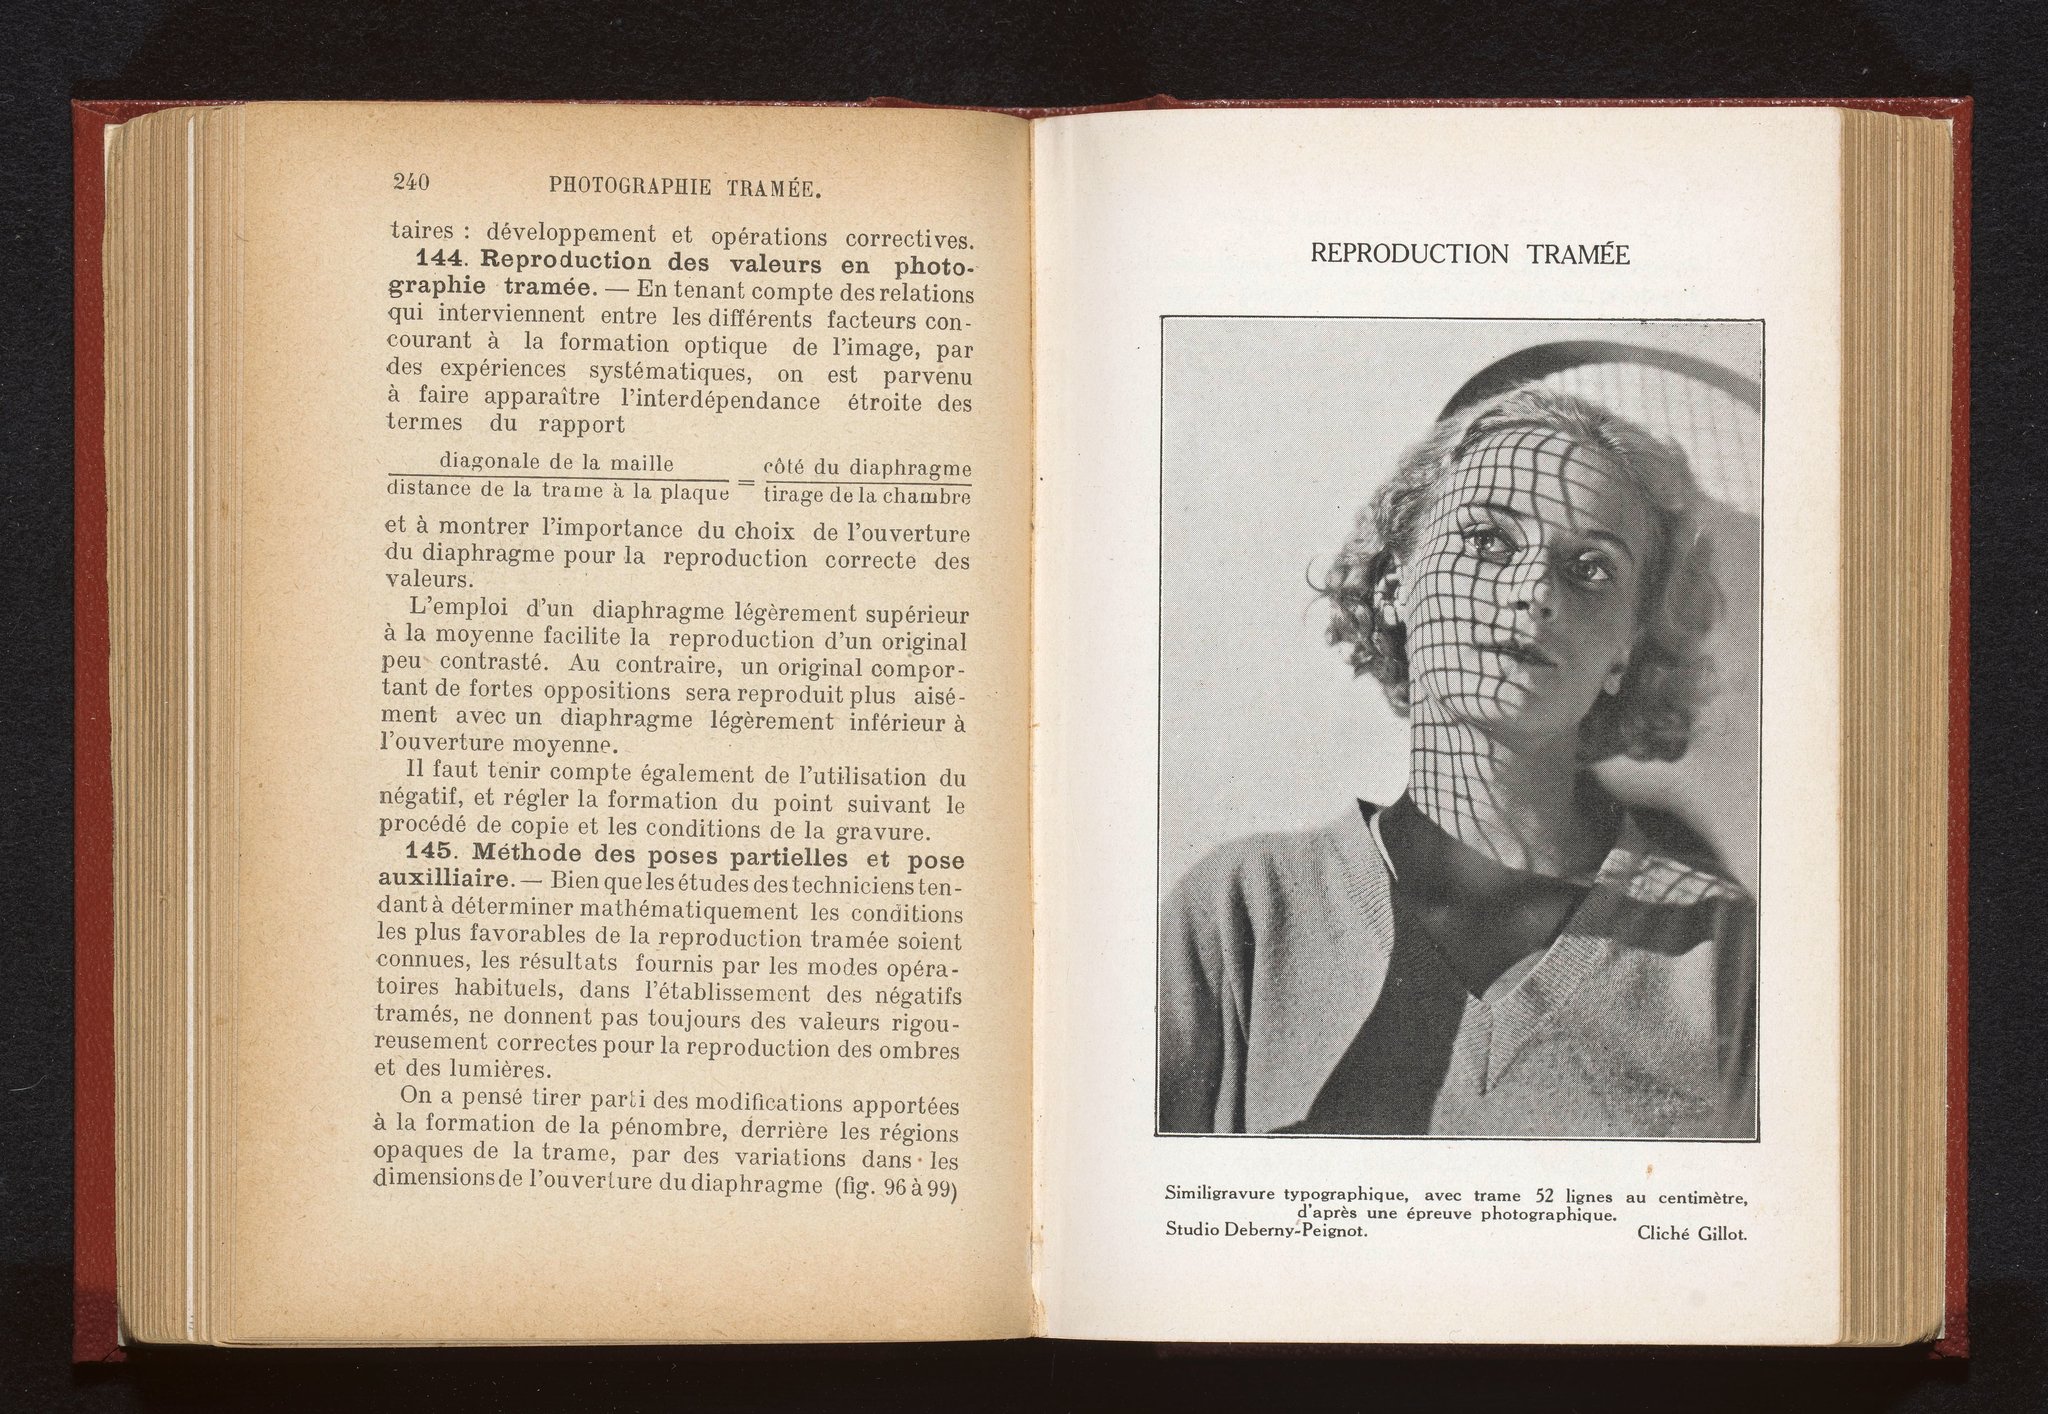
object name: page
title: Portret van een onbekende vrouw met door projectie een raster op haar gezicht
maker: Anonymous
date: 1922-1932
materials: paper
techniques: autotype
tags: adult woman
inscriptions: name: ‘Studio Deberny-Peignot.’, inscription: ‘Similigravure typographique, avec trame 52 lignes au centimètre, d'après une épreuve photographique’